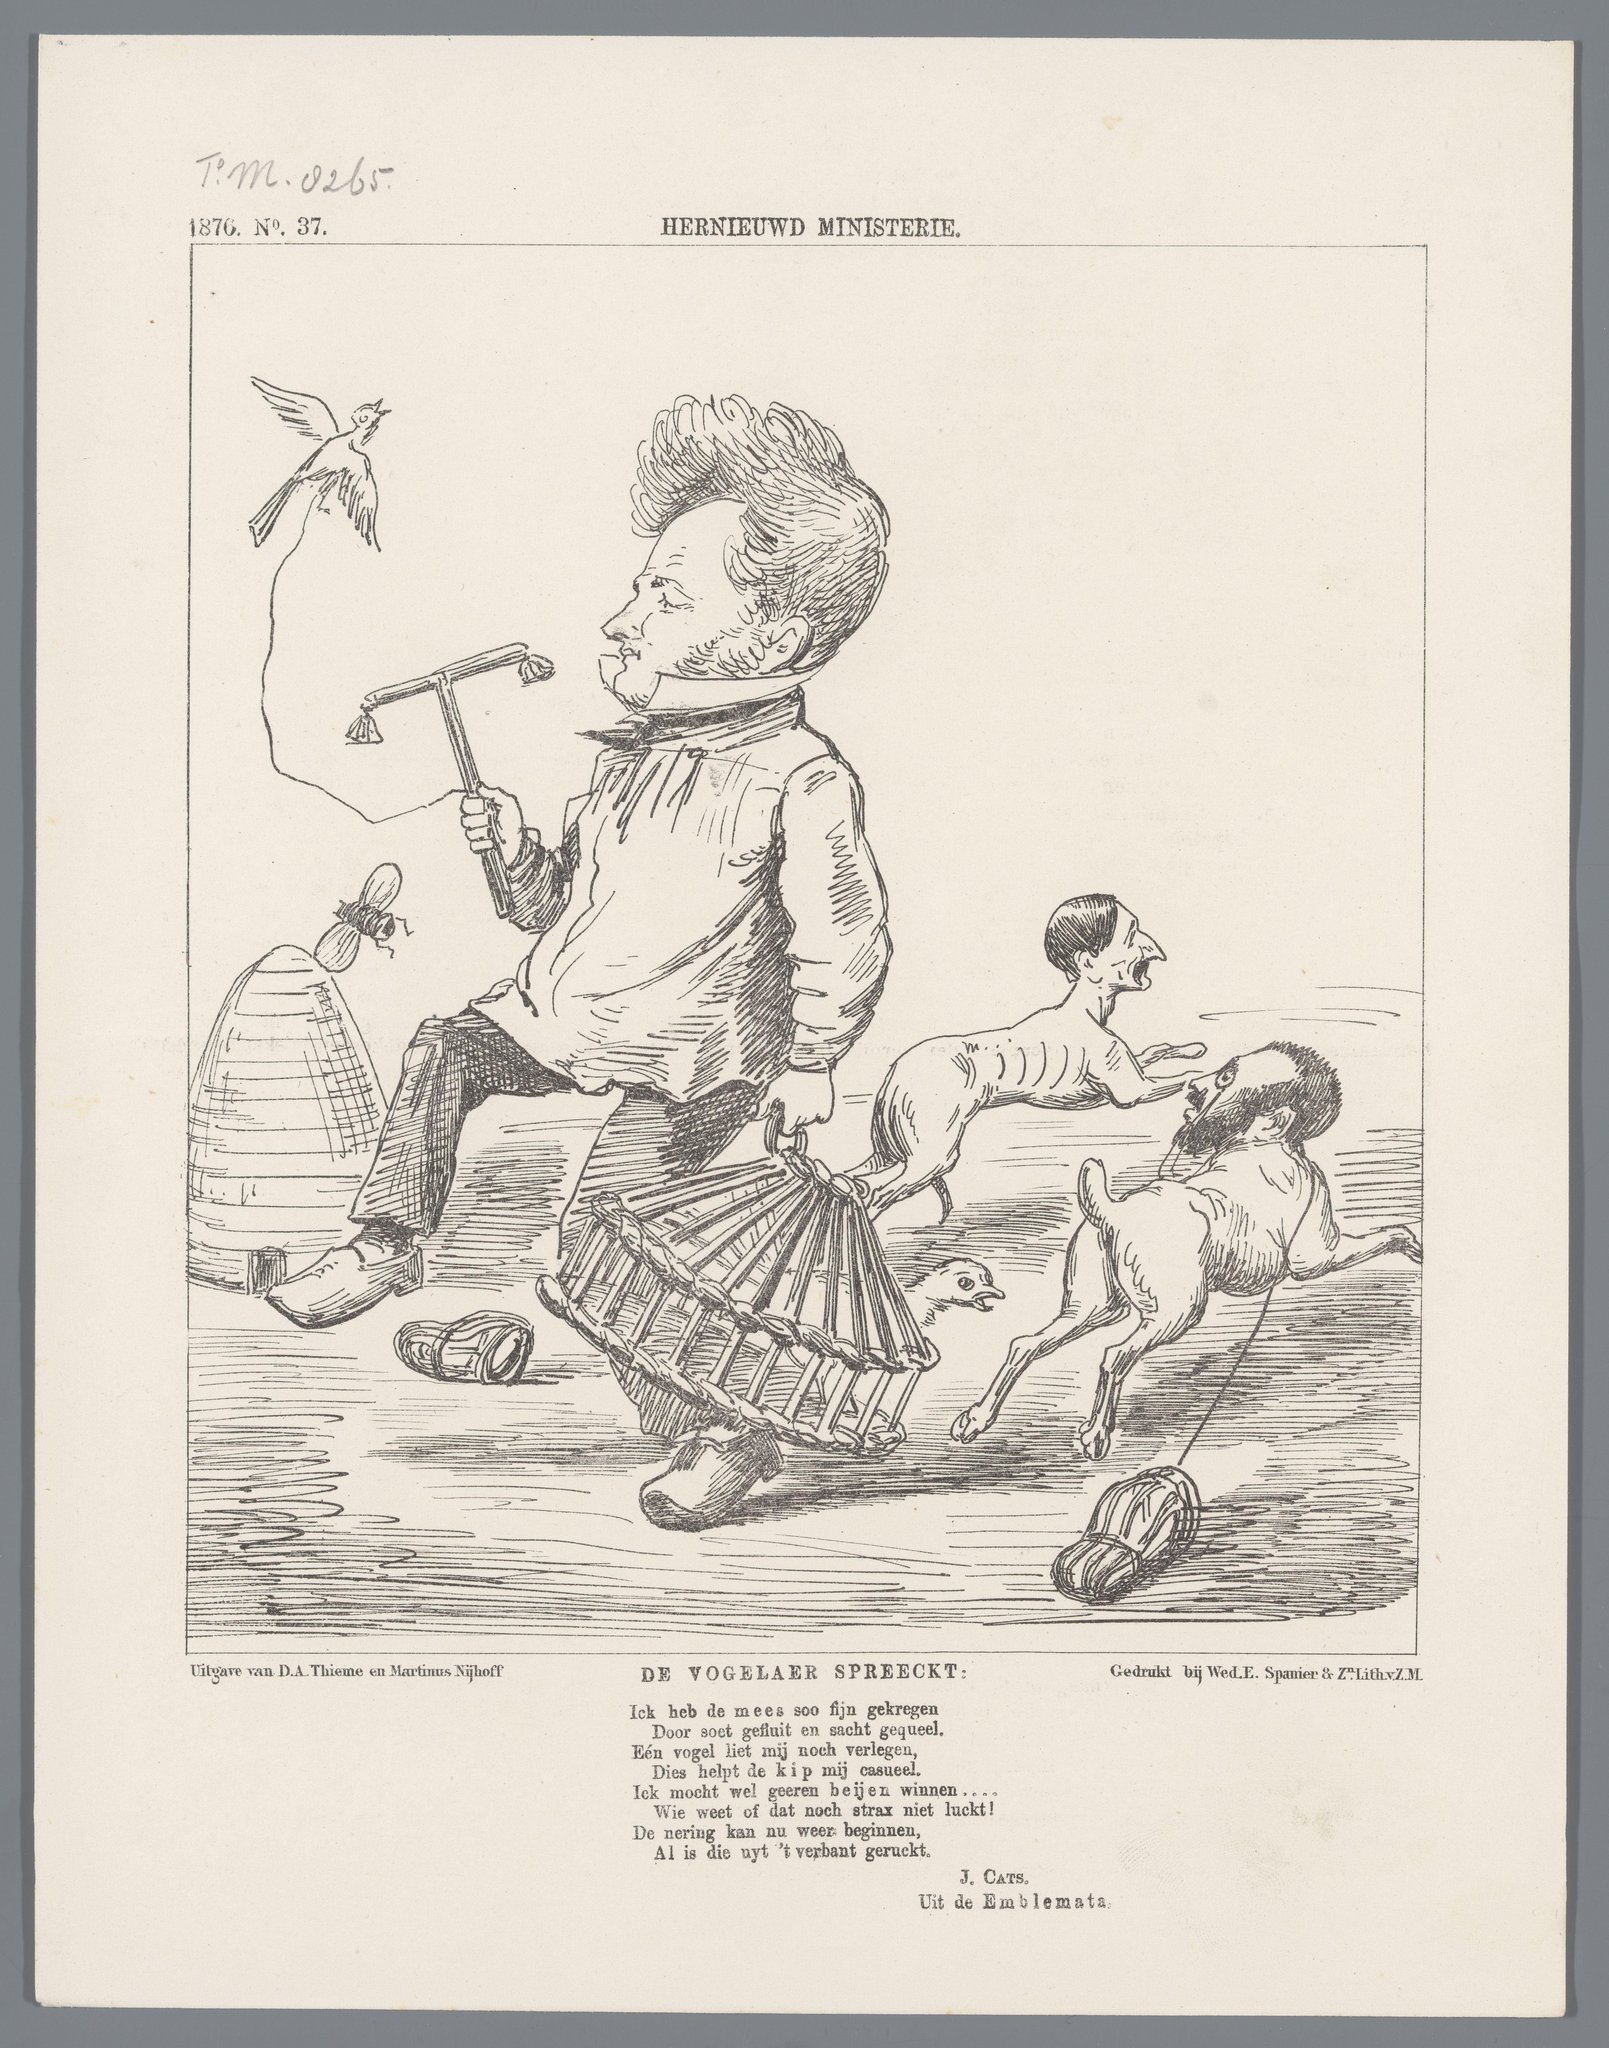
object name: print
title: Brief bij medaille aangeboden aan H.J. Caan, 1856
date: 1856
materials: paper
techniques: lithograph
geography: netherlands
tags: paris, london, napoleon iii (keizer der fransen), the hague, politician, hendrik johan caan van hoekenburg, medal (considered as a piece of sculpture, regardless of its specific function)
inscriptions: collector's mark: Lugt 2228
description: Diploma of brief behorend bij de zilveren medaille in 1856 aangeboden aan Jhr. Mr. Hendrik Johan Caan, als bewijs van erkentelijkheid voor het werk door hem verricht als president van de 's-Gravenhaagsche Sub-Commissie voor de Wereldtentoonstelling te Parijs van 1855. Centraal de medaille en de tekst. Geheel binnen een ornamentele omlijsting met bovenaan een allegorische vrouwenfiguur met het wapen van Den Haag en allerlei attributen van de Kunsten en Wetenschappen. Verder bladranken, de wapens van Nederland en Frankrijk en een penning met buste van keizer Napoleon III.